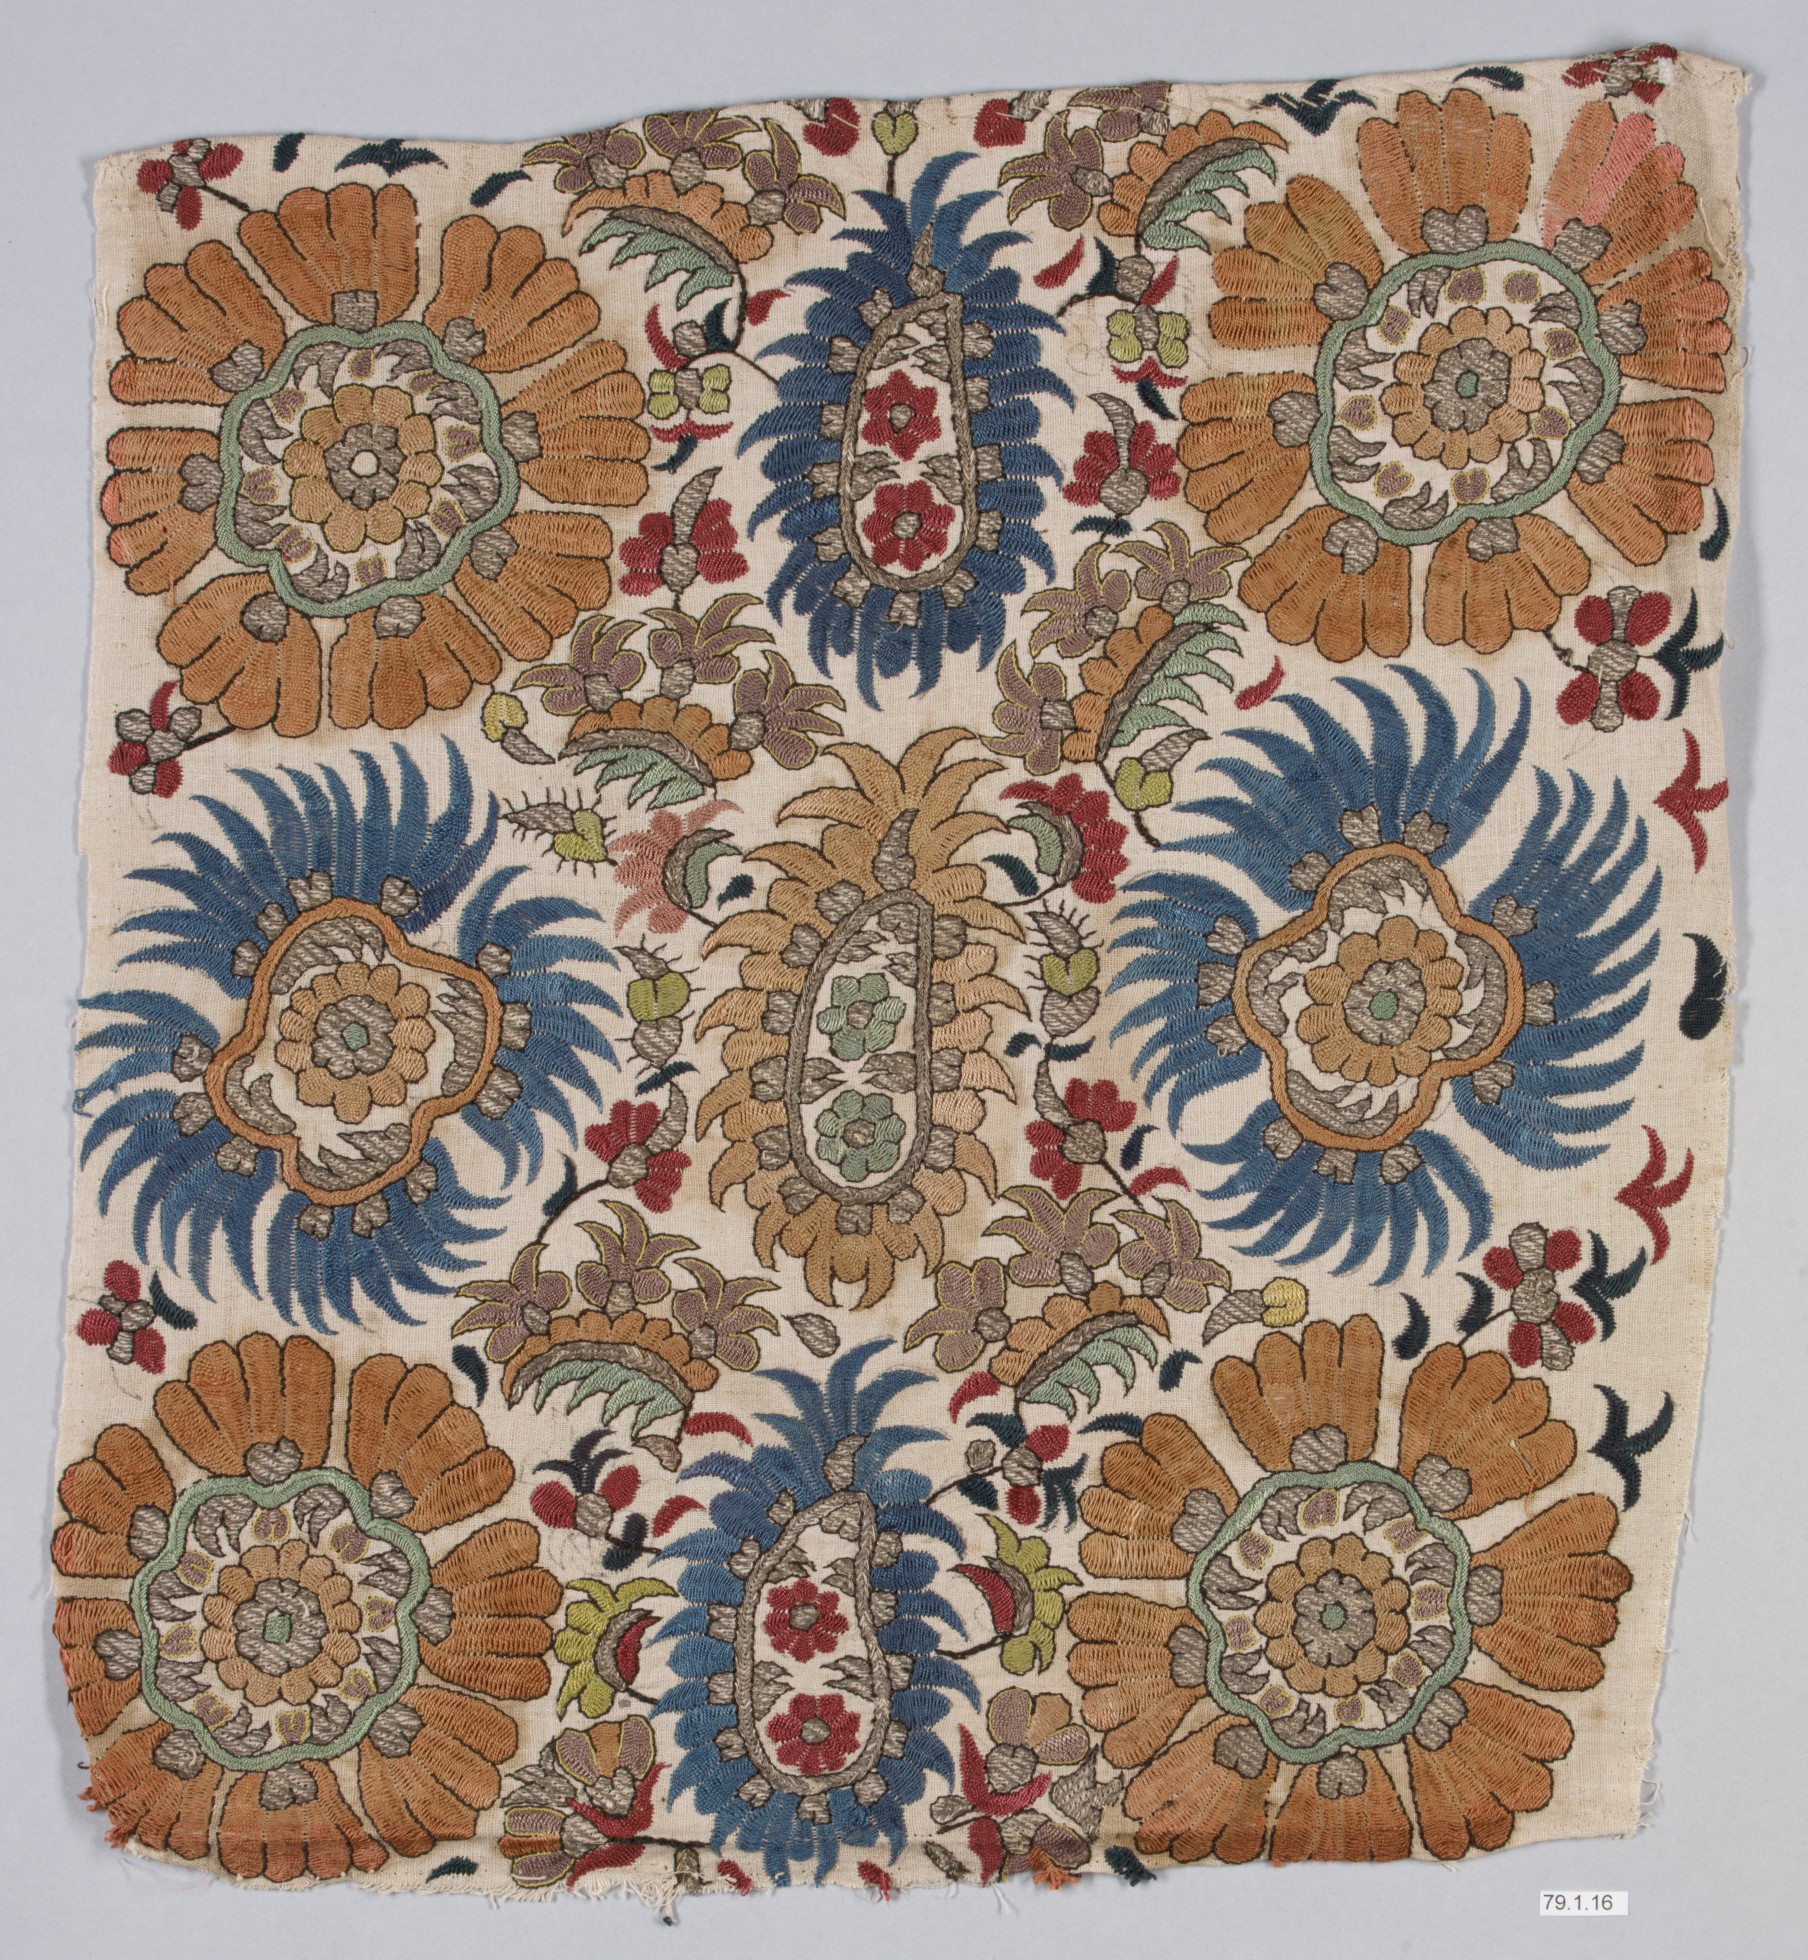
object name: textile fragment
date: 1801-1833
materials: linen, metal thread, silk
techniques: embroidery, weave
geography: turkey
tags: flowers